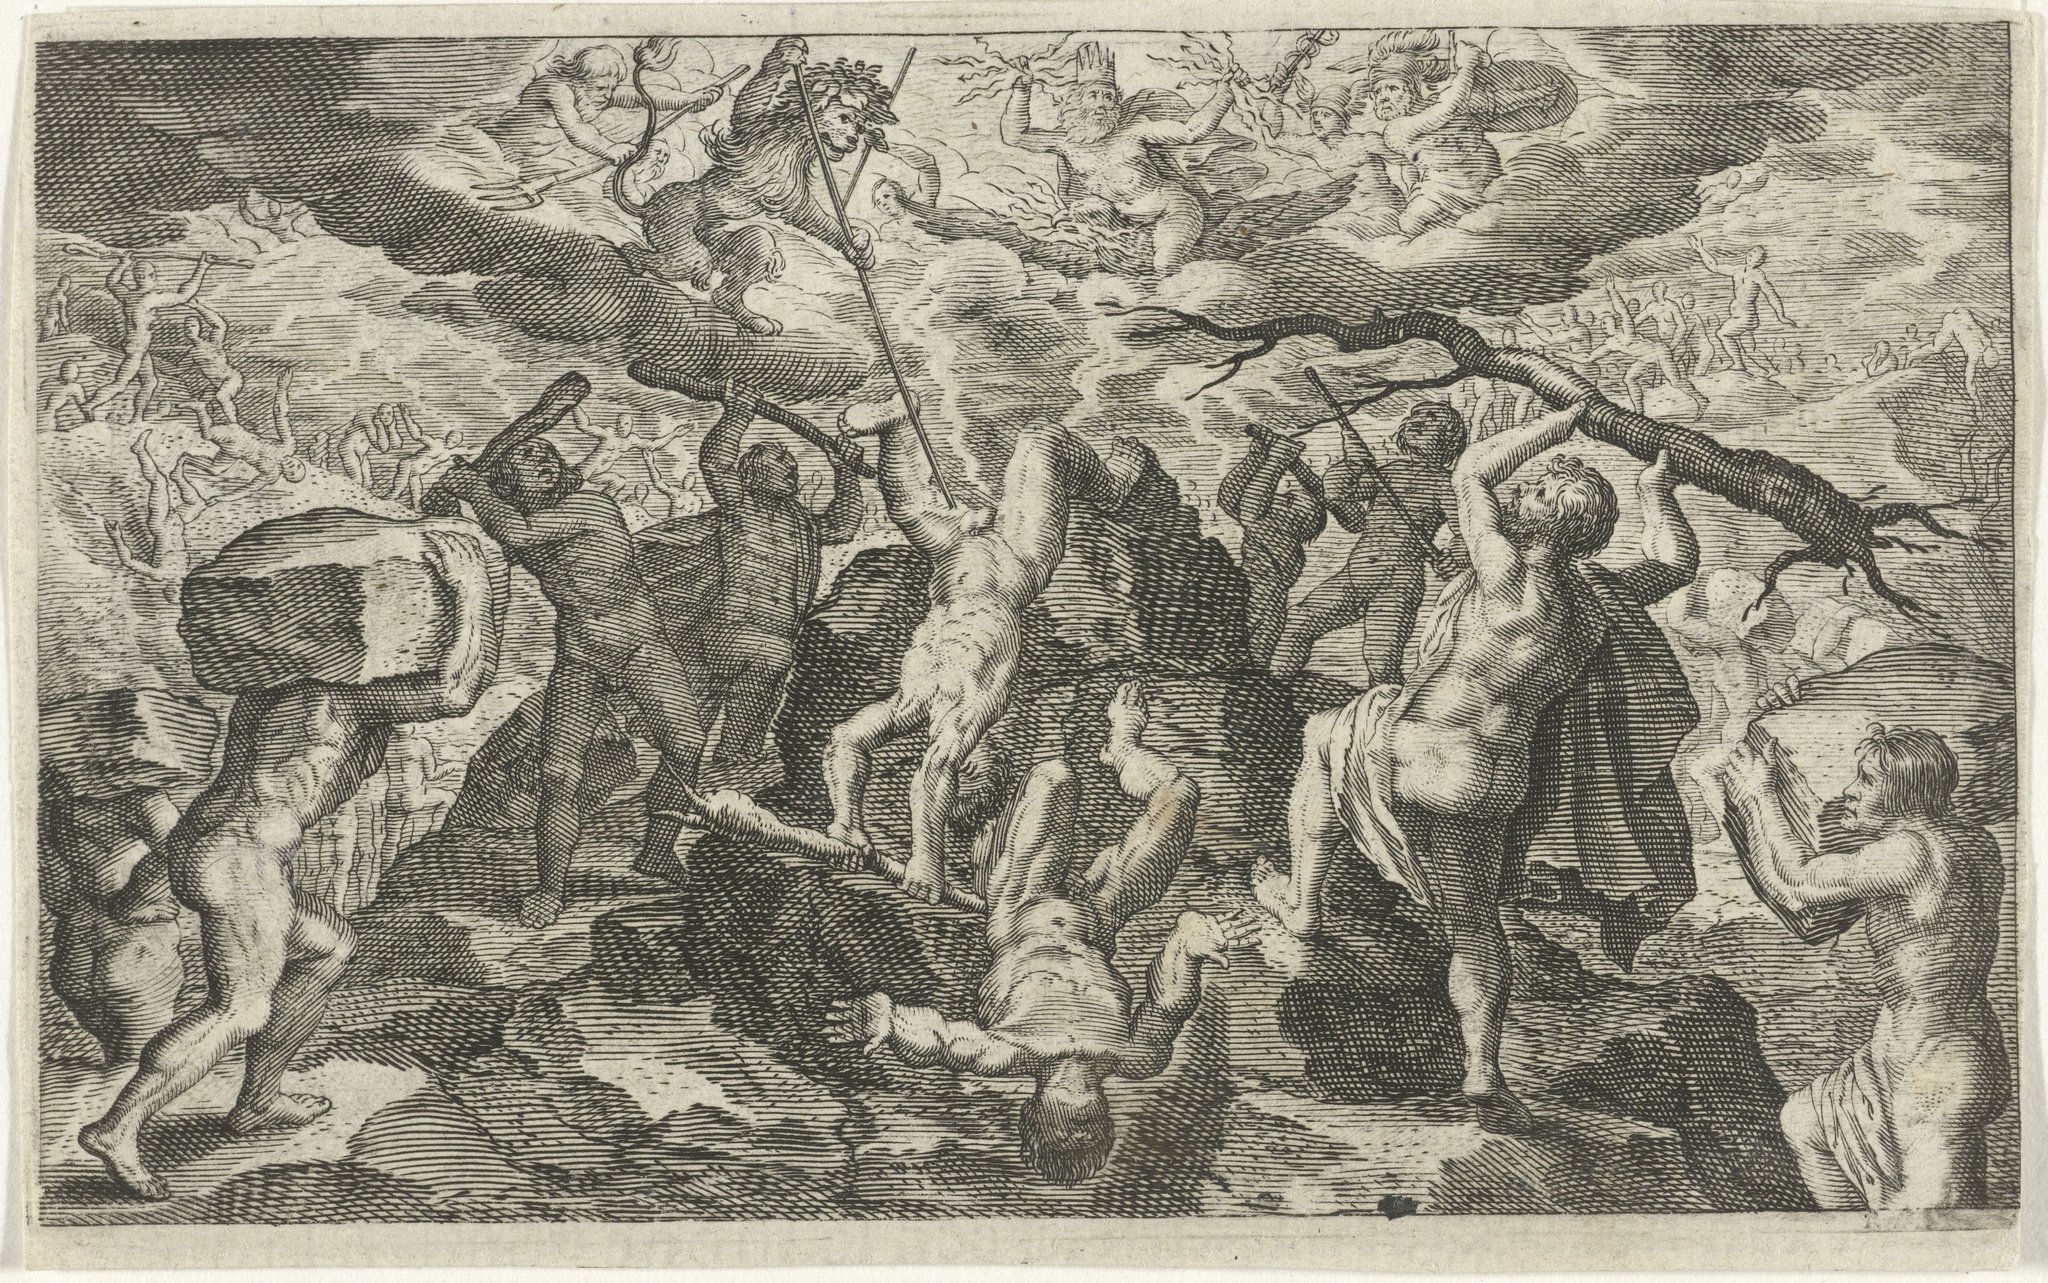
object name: book illustration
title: Bacchus helpt de Titanen verslaan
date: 1616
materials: paper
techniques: engraving, letterpress printing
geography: amsterdam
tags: war of the titans against jupiter and allies: titanomachy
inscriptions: collector's mark: Lugt 2228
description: Boekillustratie voor: Heinsius, Daniel [bewerkt door Petrus Scriverius]. Nederduytsche poemata. dl. 3: Hymnus oft Lof-sanck van Bacchus, Waerin'tgebruyck ende misbruyck vande Wijn beschreven wort. Amsterdam: Willem Jansz Blaeu, 1616.